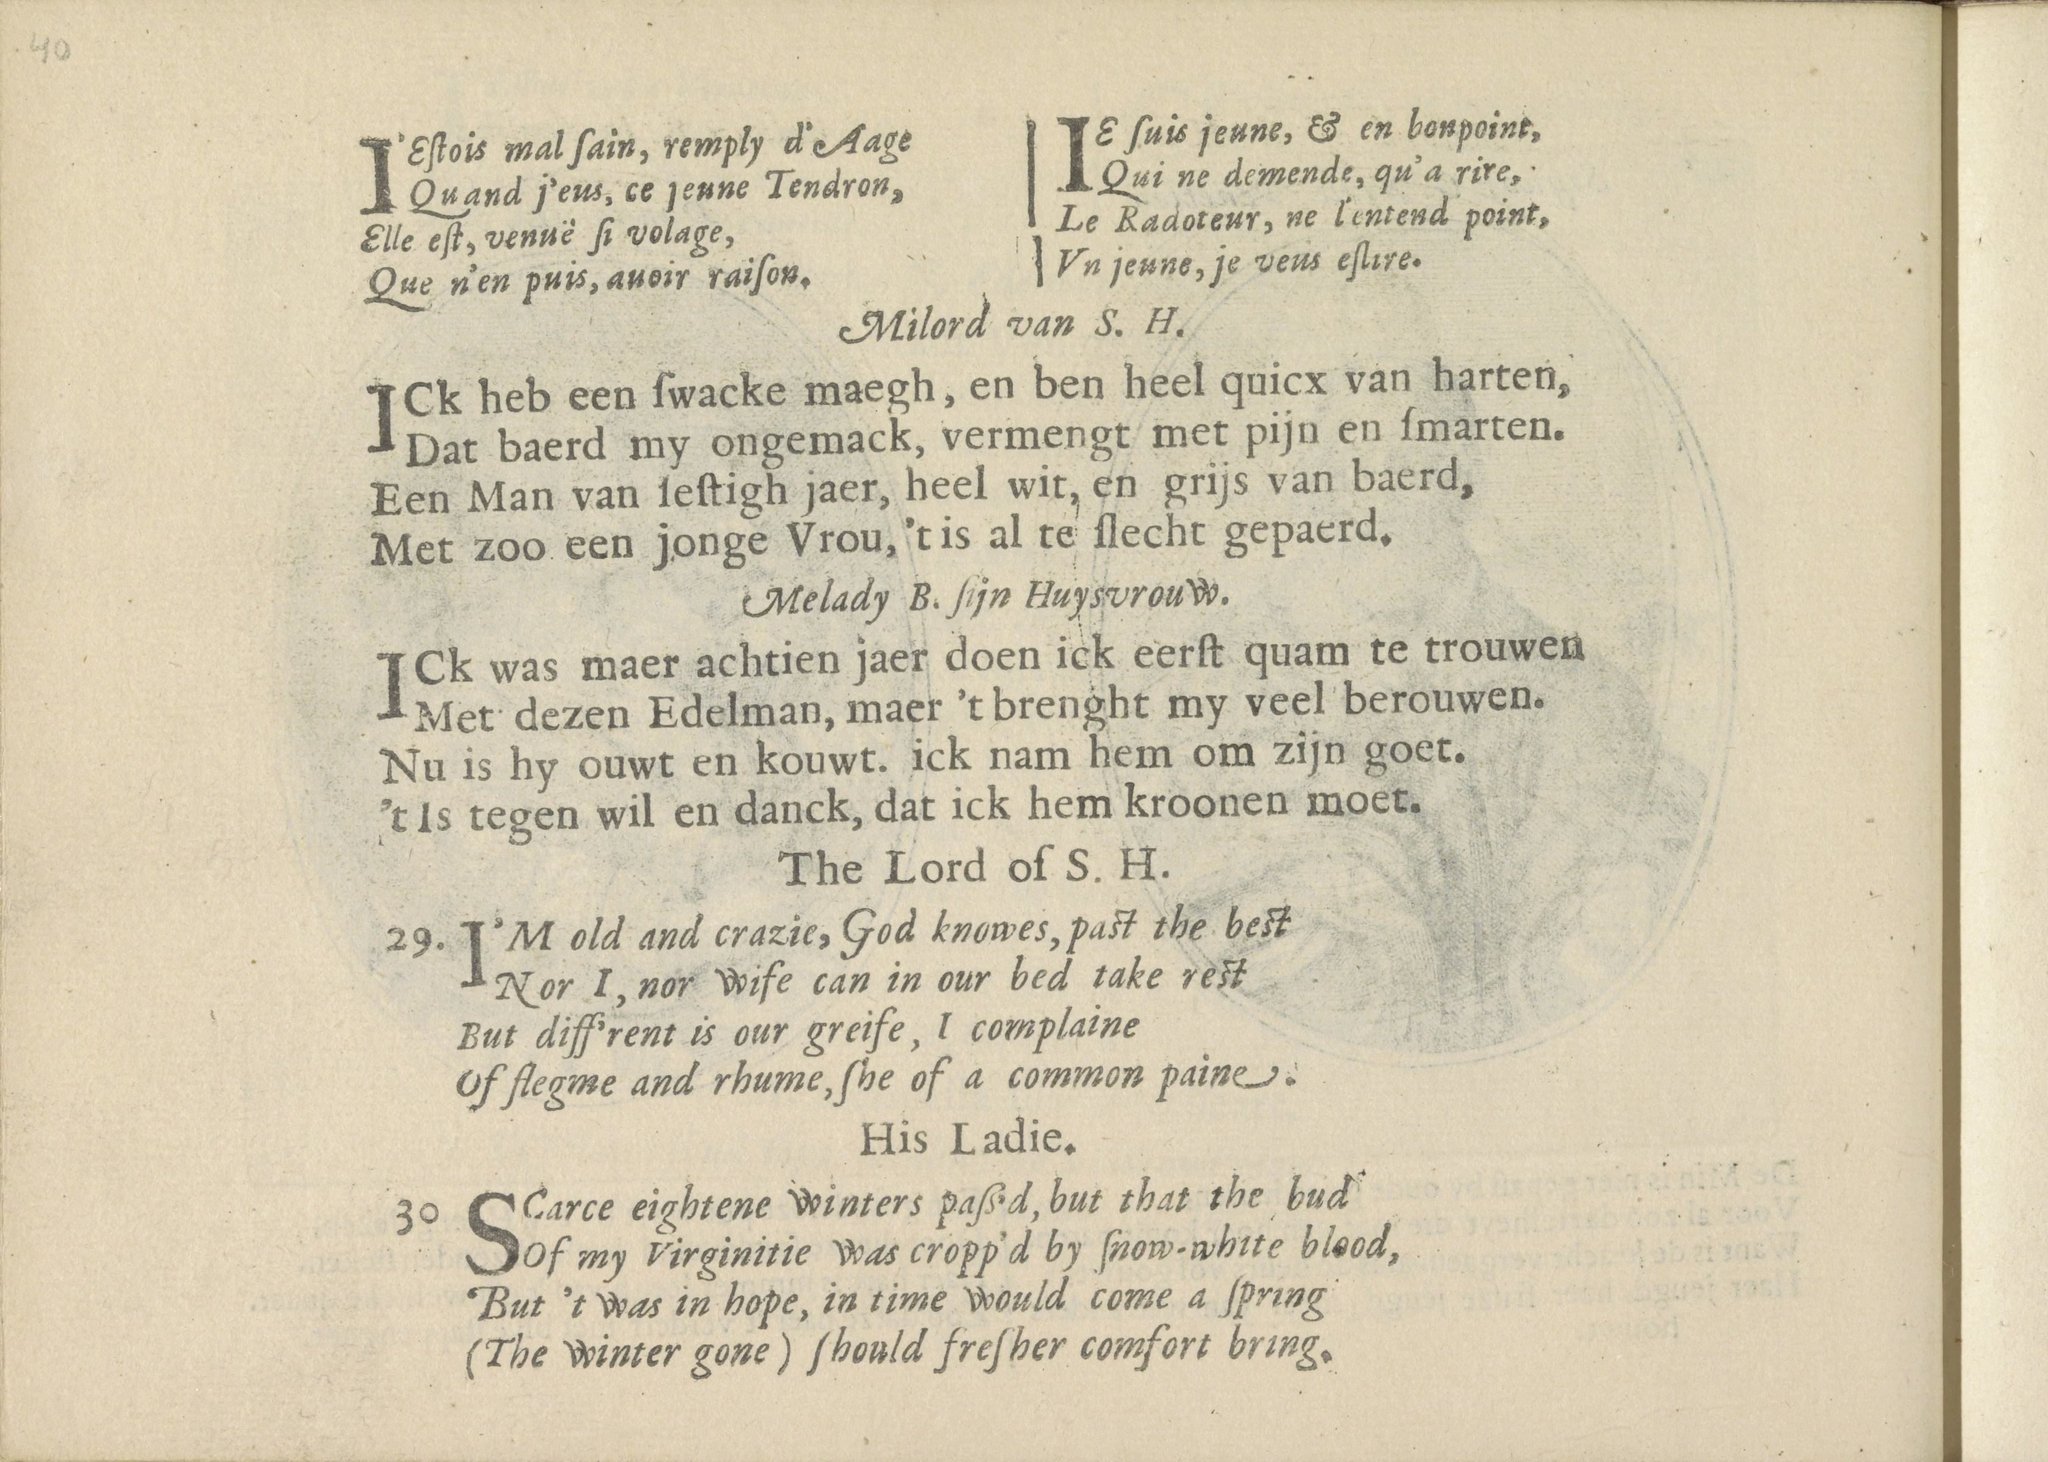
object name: album leaf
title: Les abus du mariage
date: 1641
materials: paper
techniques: letterpress printing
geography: amsterdam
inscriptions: date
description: Drie keer twee kwatrijnen in het Frans, Nederlands en Engels bij voorstellingen van de Heer van S.H. en zijn vrouw. Het blad maakt deel uit van een album.